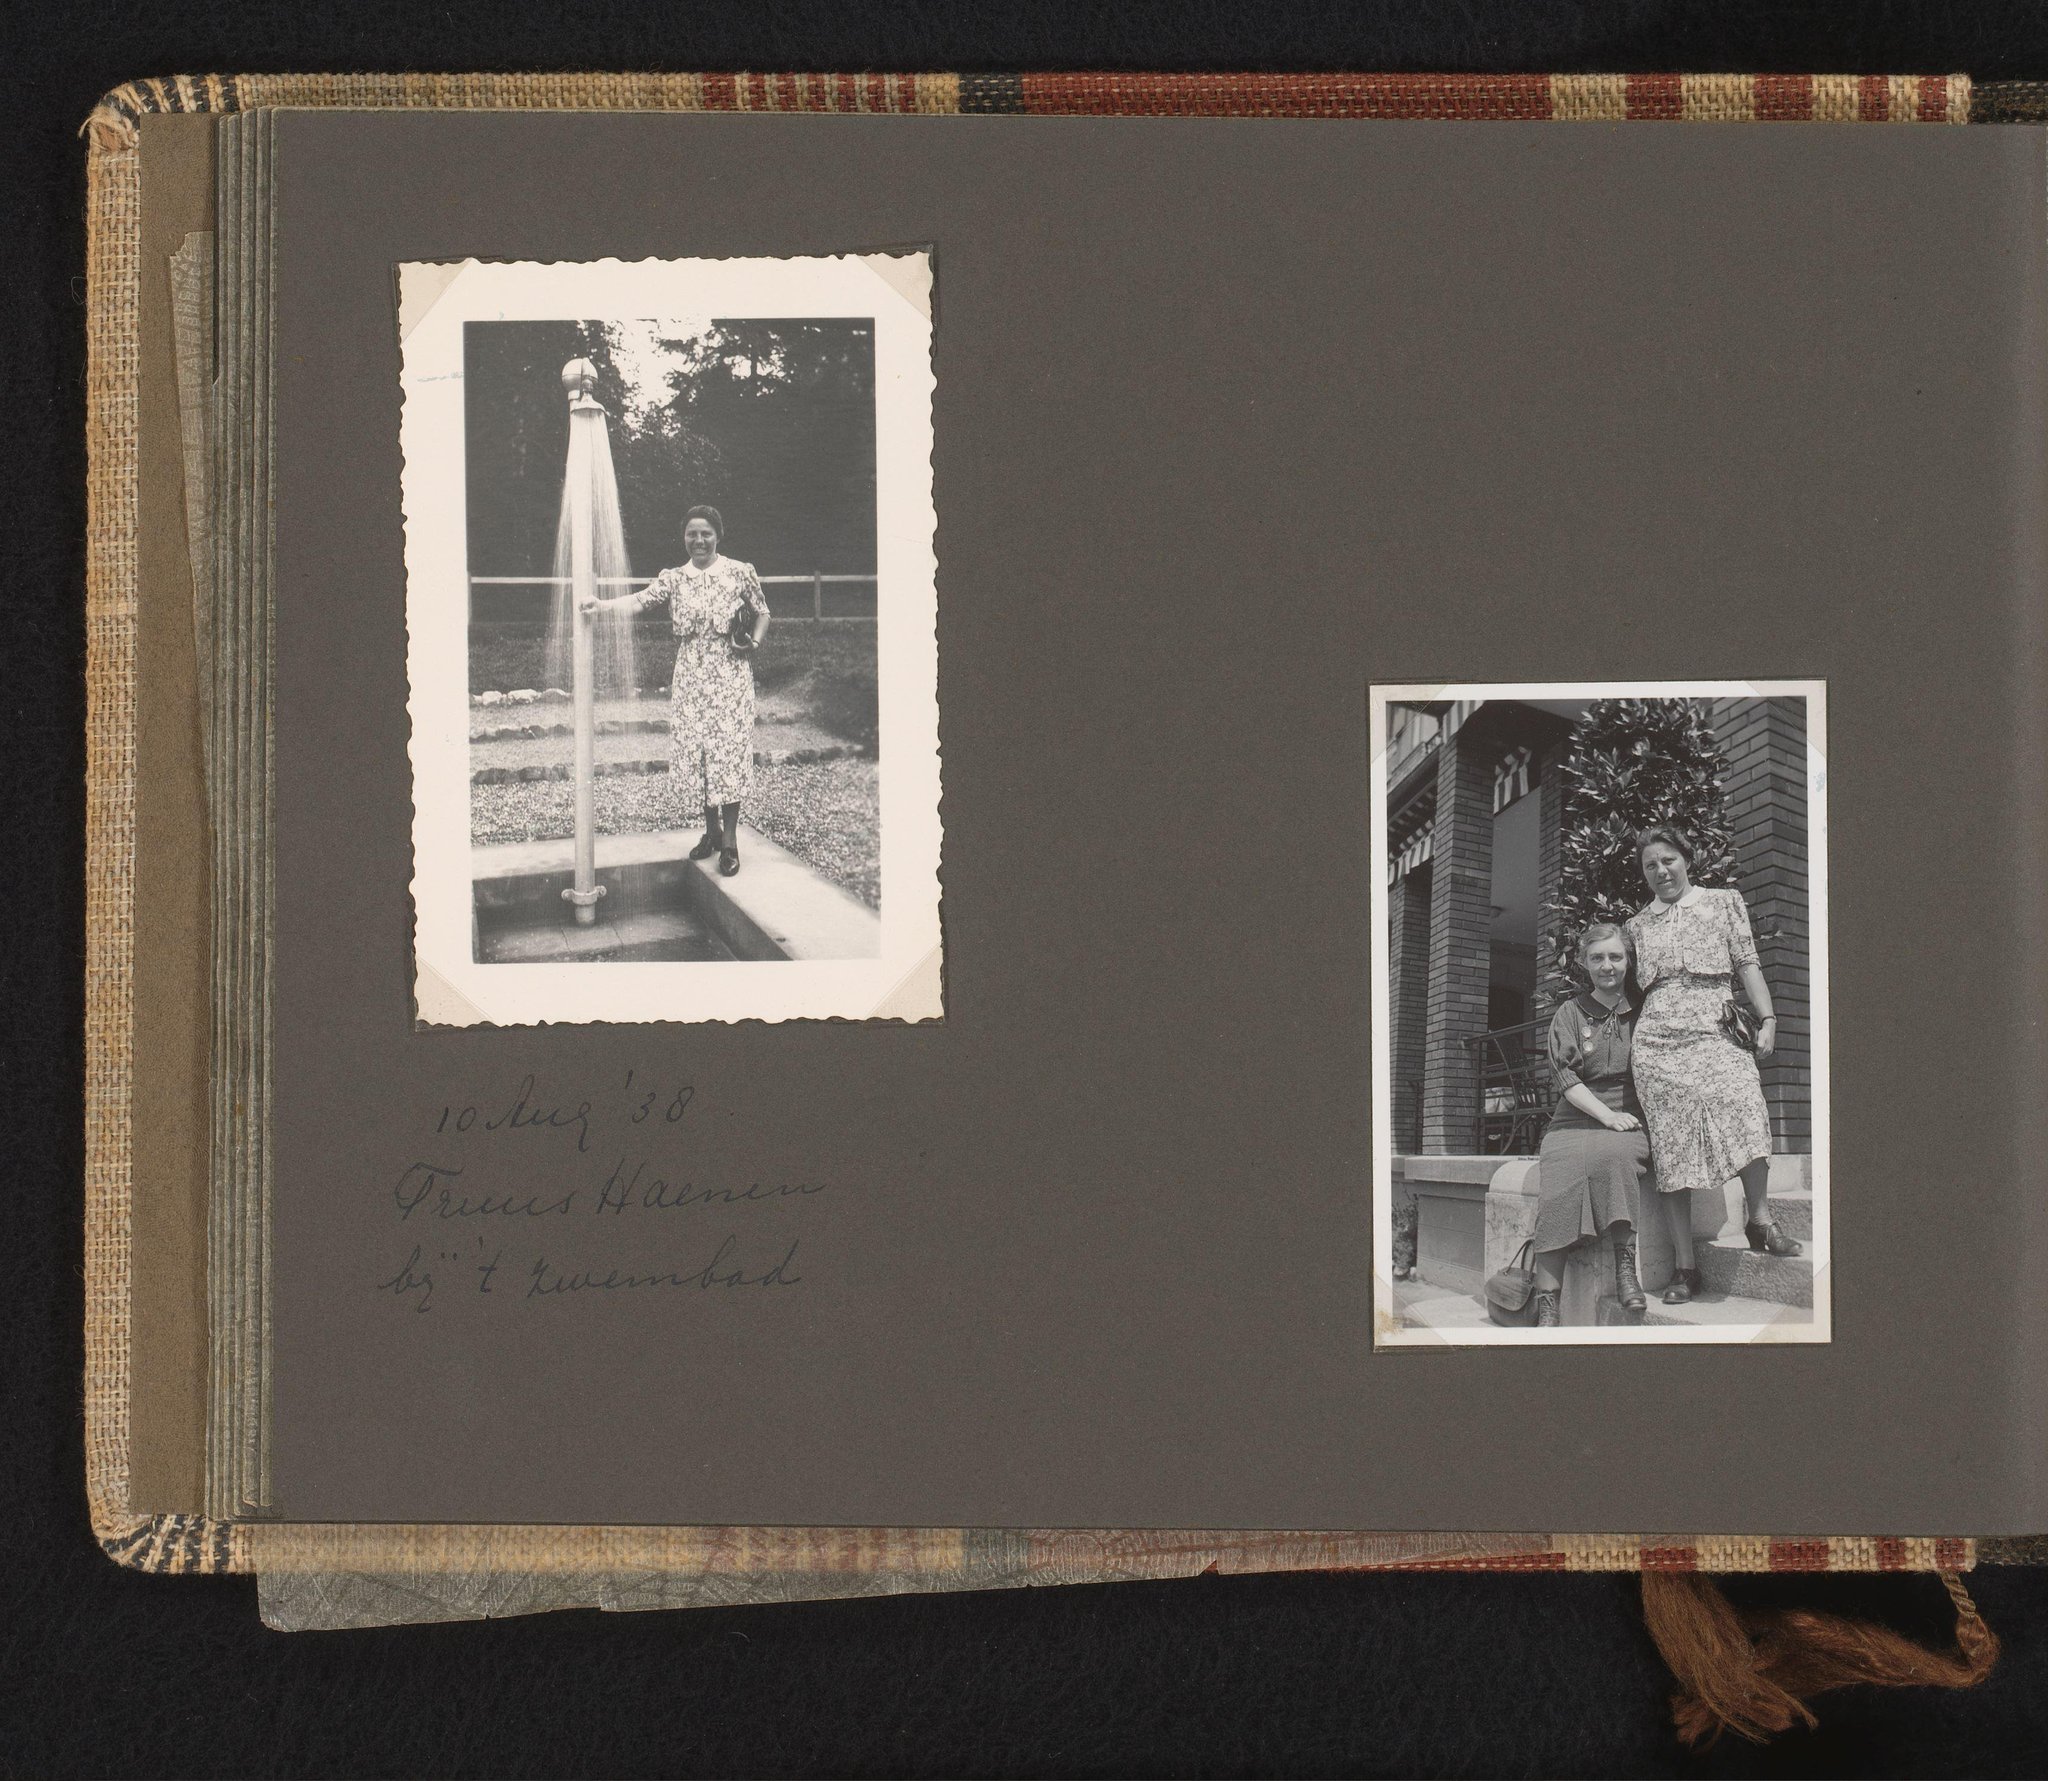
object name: album leaf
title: Portretten van vrouwen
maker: Anonymous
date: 1938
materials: paper, photographic support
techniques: gelatin silver print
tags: adult woman, shower, historical persons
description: Een portret van Truus Haenen bij een douche en een portret van Truus Haenen met een andere vrouw. Deze pagina is onderdeel van een album.